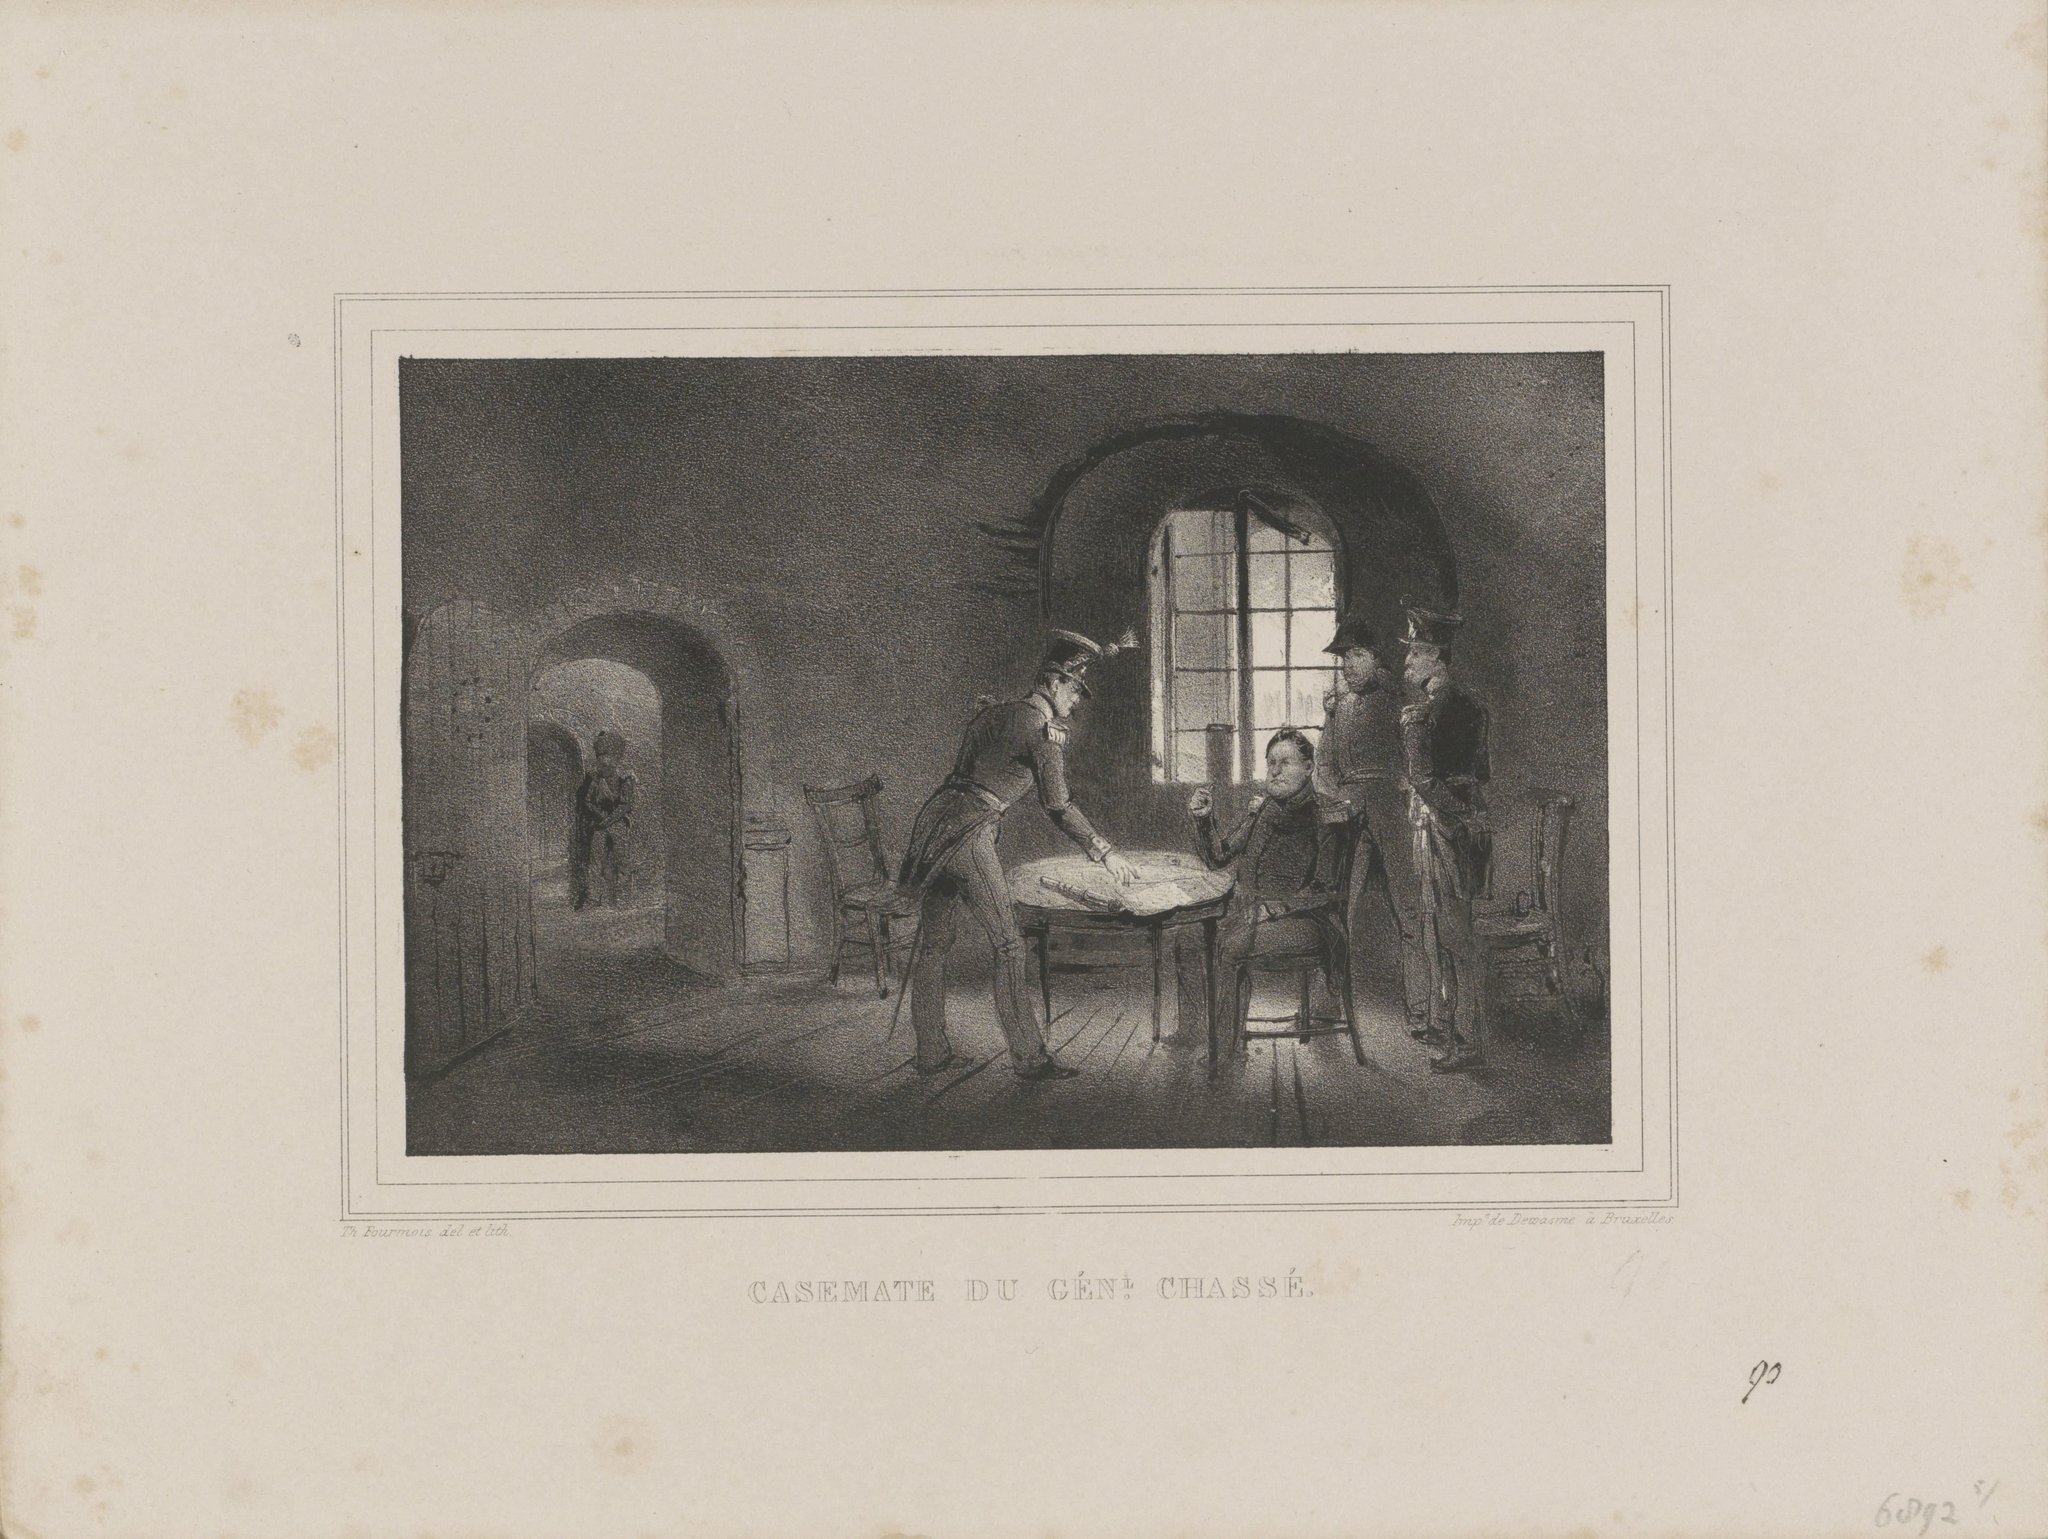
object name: print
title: Casemate du Gen.l Chassé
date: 1833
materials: paper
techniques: lithograph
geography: antwerp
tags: david hendrik baron chassé, permanent fortifications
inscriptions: collector's mark: Lugt 2228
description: Gezicht in de bunker of kazemat van generaal Chassé tijdens het beleg, 1832. De generaal zit aan tafel, om hem heen staan leden van zijn generale staf. Onderdeel van een serie van zes platen uit 1833 van de ruïnes van de citadel na het beleg door het Franse leger in november en december 1832.